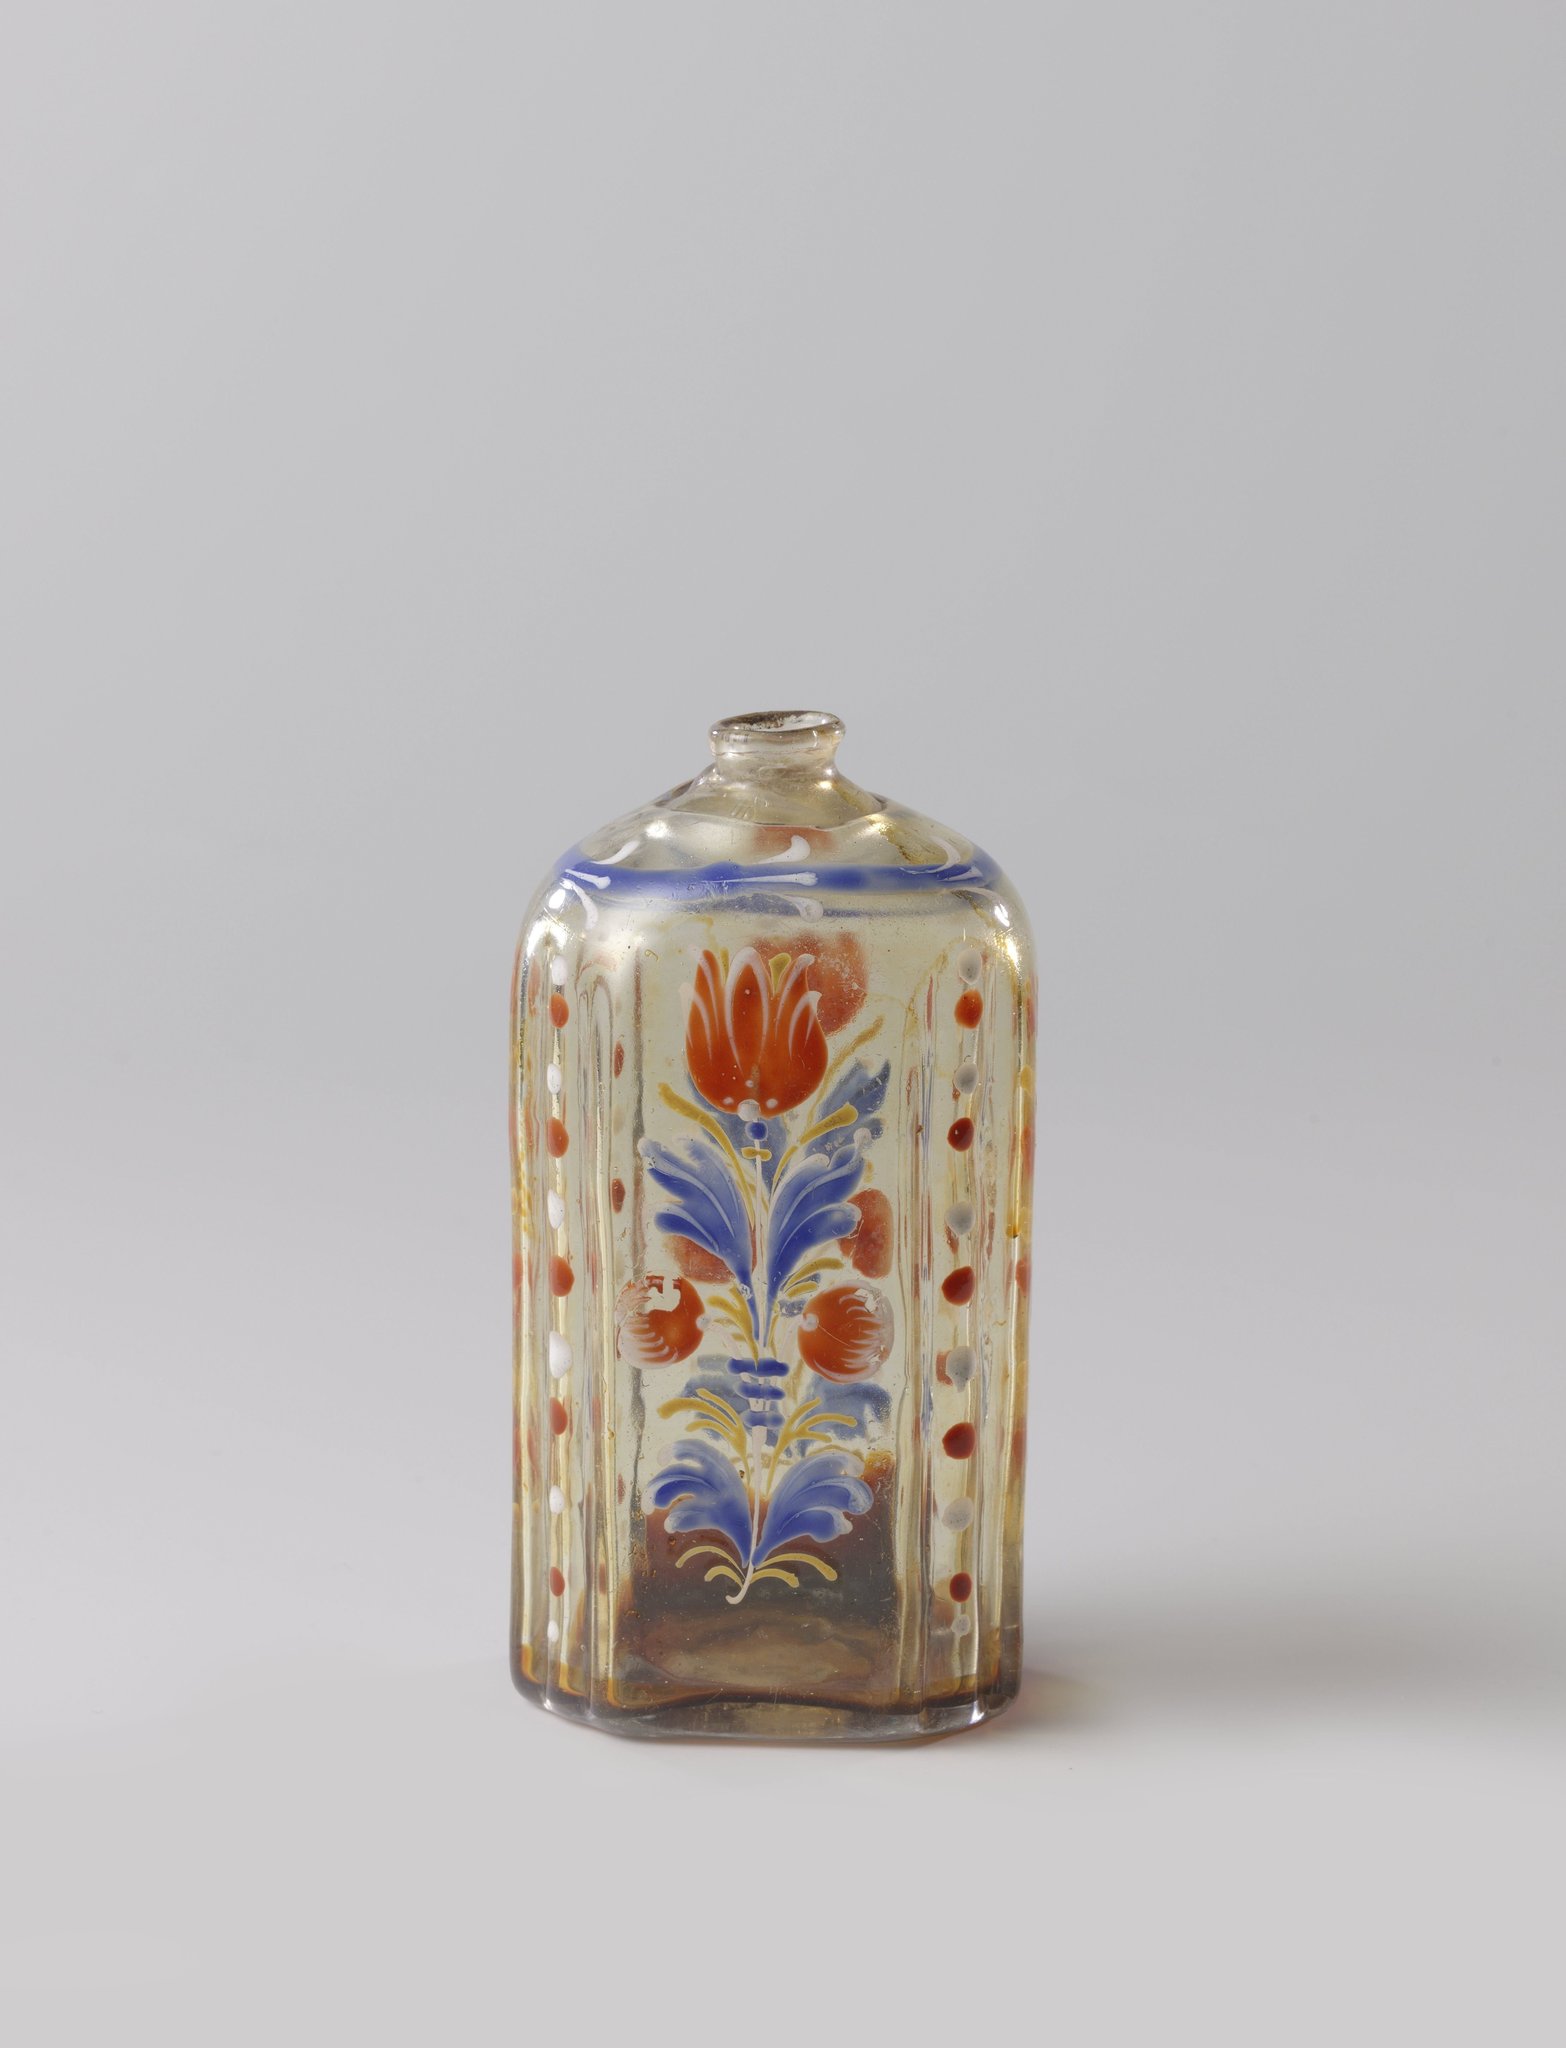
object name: bottle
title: Fles met bloemtakken, ranken en stippen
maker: Anonymous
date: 1700-1800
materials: glass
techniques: glassblowing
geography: central europe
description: Vlakke bodem, rechthoekig, in de vorm geblazen lichaam met geprofileerde hoeken met in wit, geel, blauw en rood een gestileerde bloemtak op voor- en achterzijde en ranken en stippen op de smalle zijden en de hoeken.